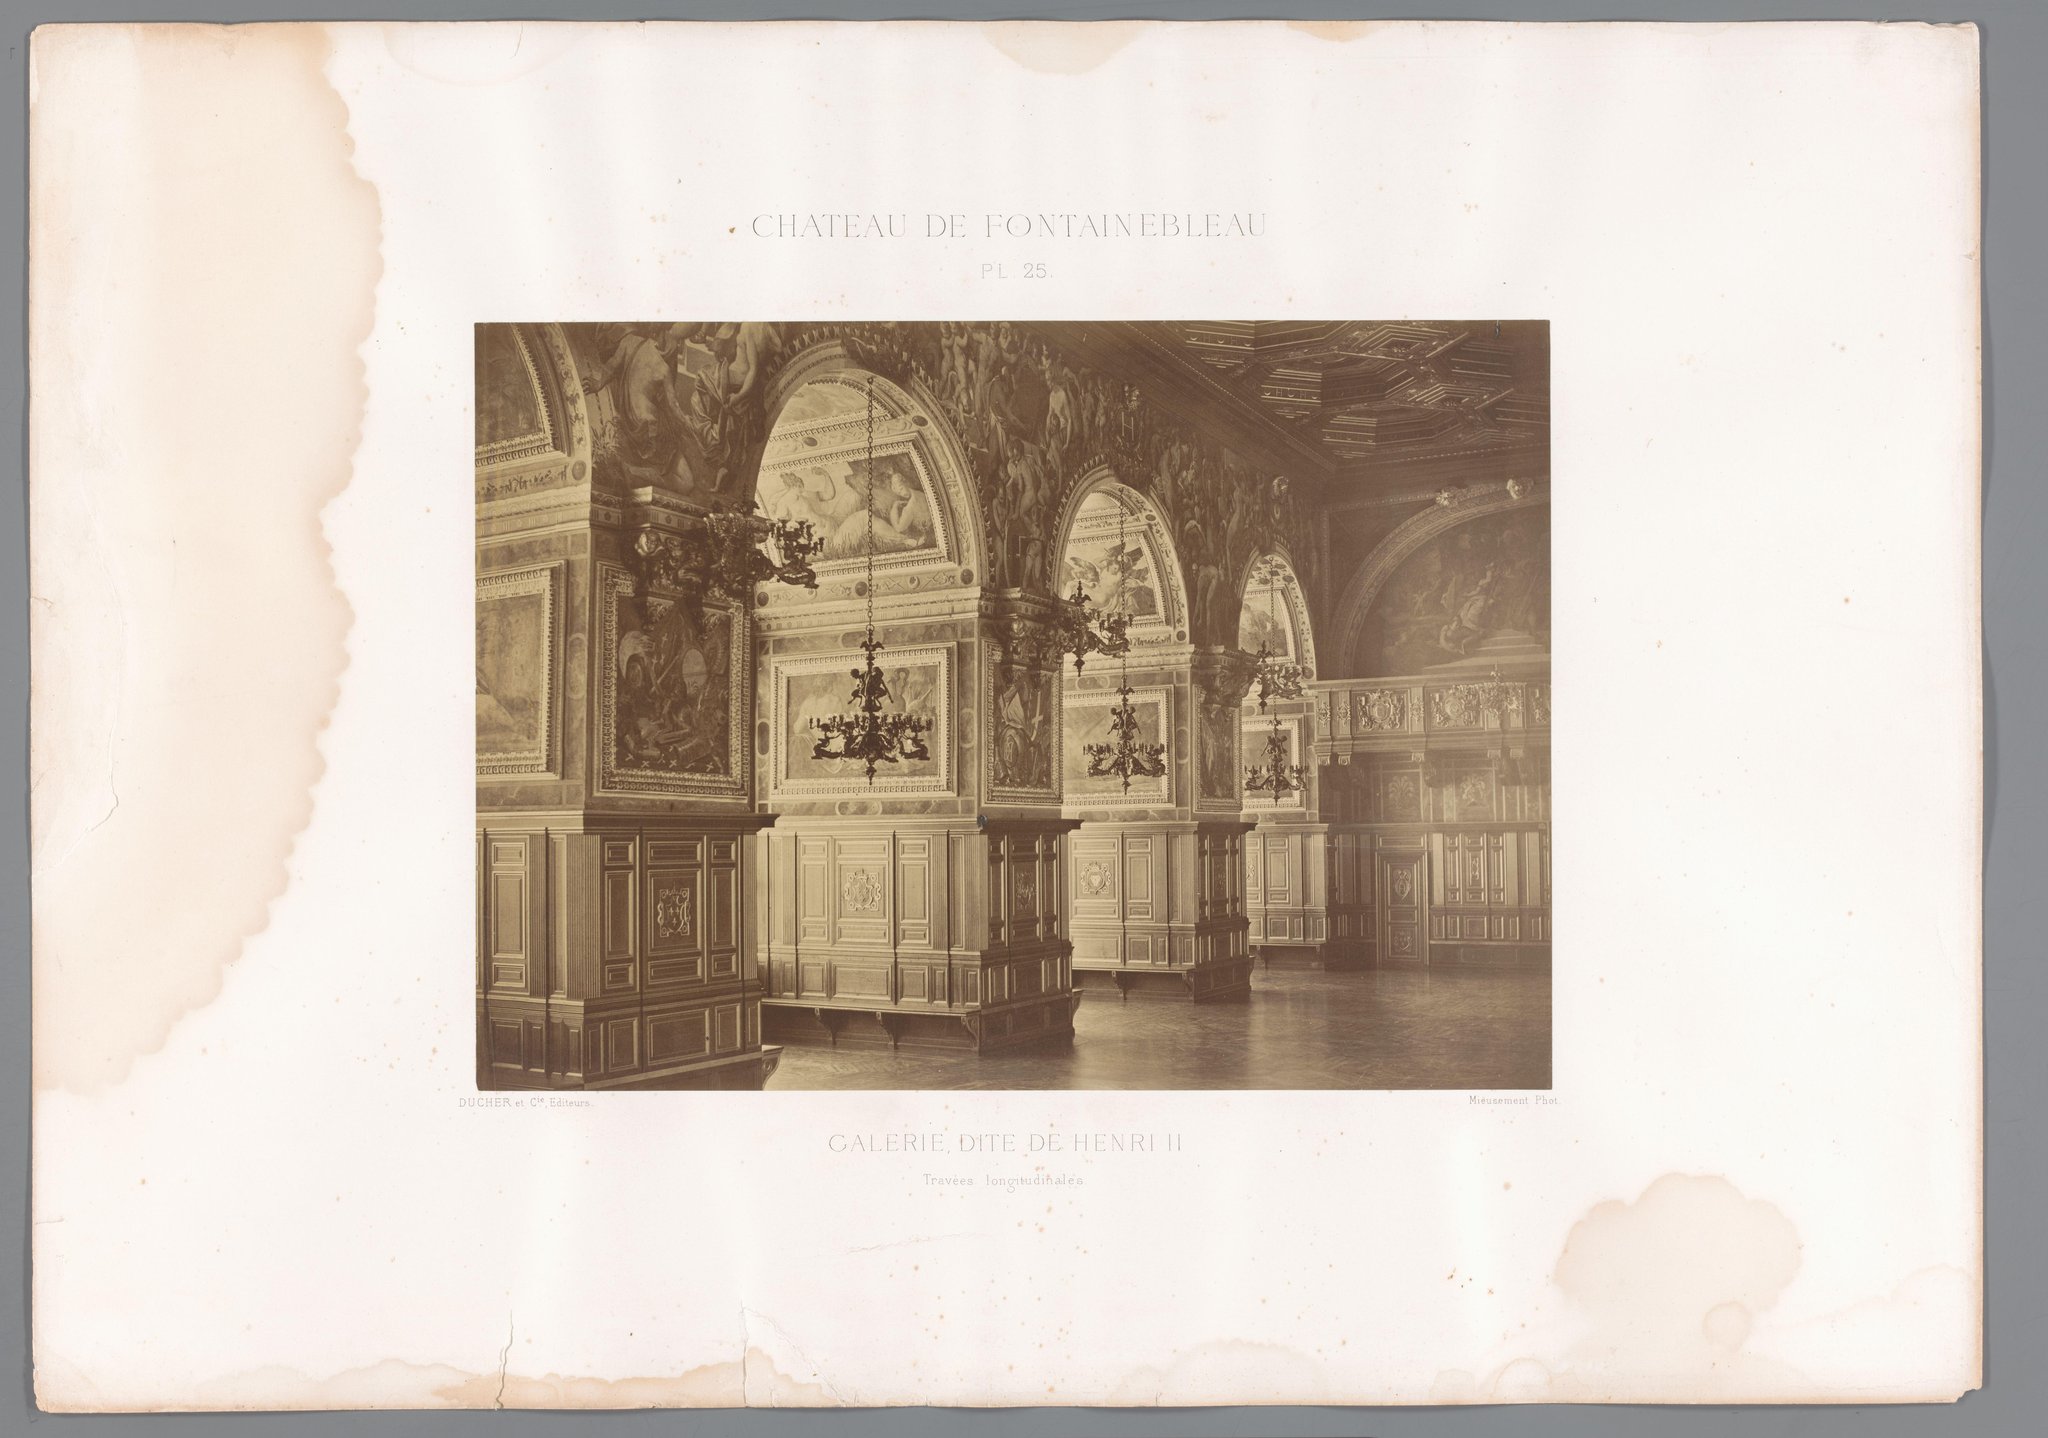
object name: photograph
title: Gezicht op nissen in de Galerie Henri II van het Kasteel van Fontainebleau, Frankrijk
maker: séraphin-médéric mieusement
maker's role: fotograaf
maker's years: 1840-1905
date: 1870-1875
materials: photographic support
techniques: albumen print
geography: fontainebleau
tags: castle - aa - civic architecture: inside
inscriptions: number: ‘PL. 25.’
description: Deze foto maakt deel uit van een omslag met dertig foto's en twee tekstbladen.